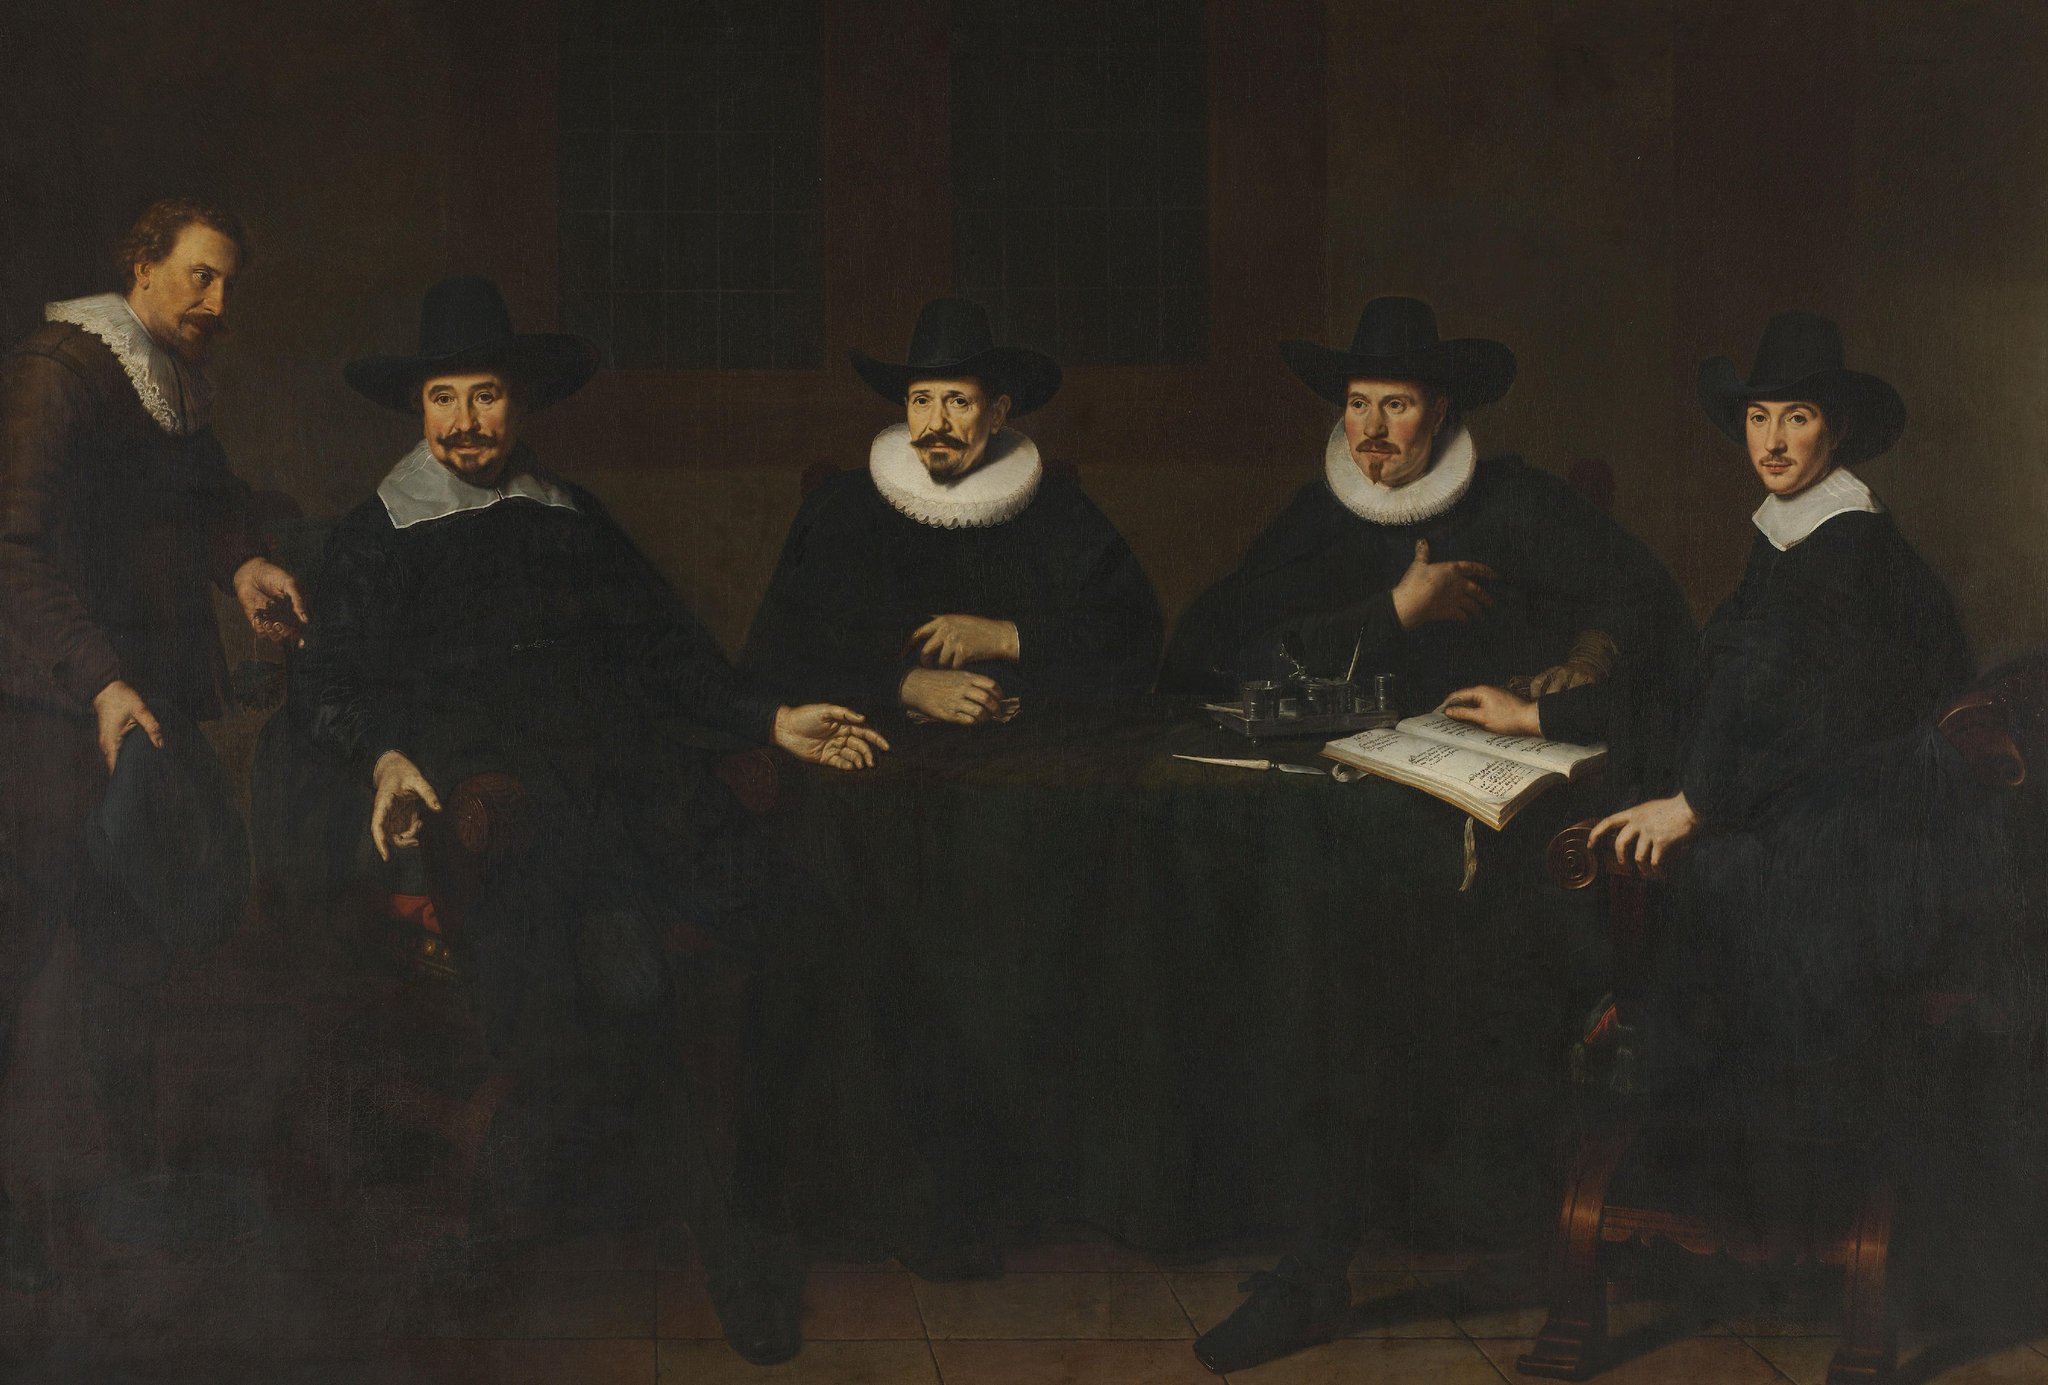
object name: painting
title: The Directors of the Serge Cloth Industry, Amsterdam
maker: dirck van santvoort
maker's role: draughtsman, painter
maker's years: 1610-1680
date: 1643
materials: canvas, oil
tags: board of a guild, historical persons, officers trusted with control of quality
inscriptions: inscription, centre right, at the bottom of the book’s left page: ‘Anno 1643 dese gedaen naer Sr. Jacques de Win, Pieter Noordijck, Gerrit Kuycken, Gerbrant Anslo’, signature and date, top right: ‘D.D. Santvoort fec. 1643’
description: De hoofdlieden van de Saainering te Amsterdam in 1643, gezeten in stoelen rond een tafel. Rechts een opengeslagen boek en een inktstel. Afgebeeld zijn (van links naar rechts): de knecht Jan Stockmans, Jacques de Win, Pieter Noordijck, Gerrit Kuycken en Gerrit Anslo.